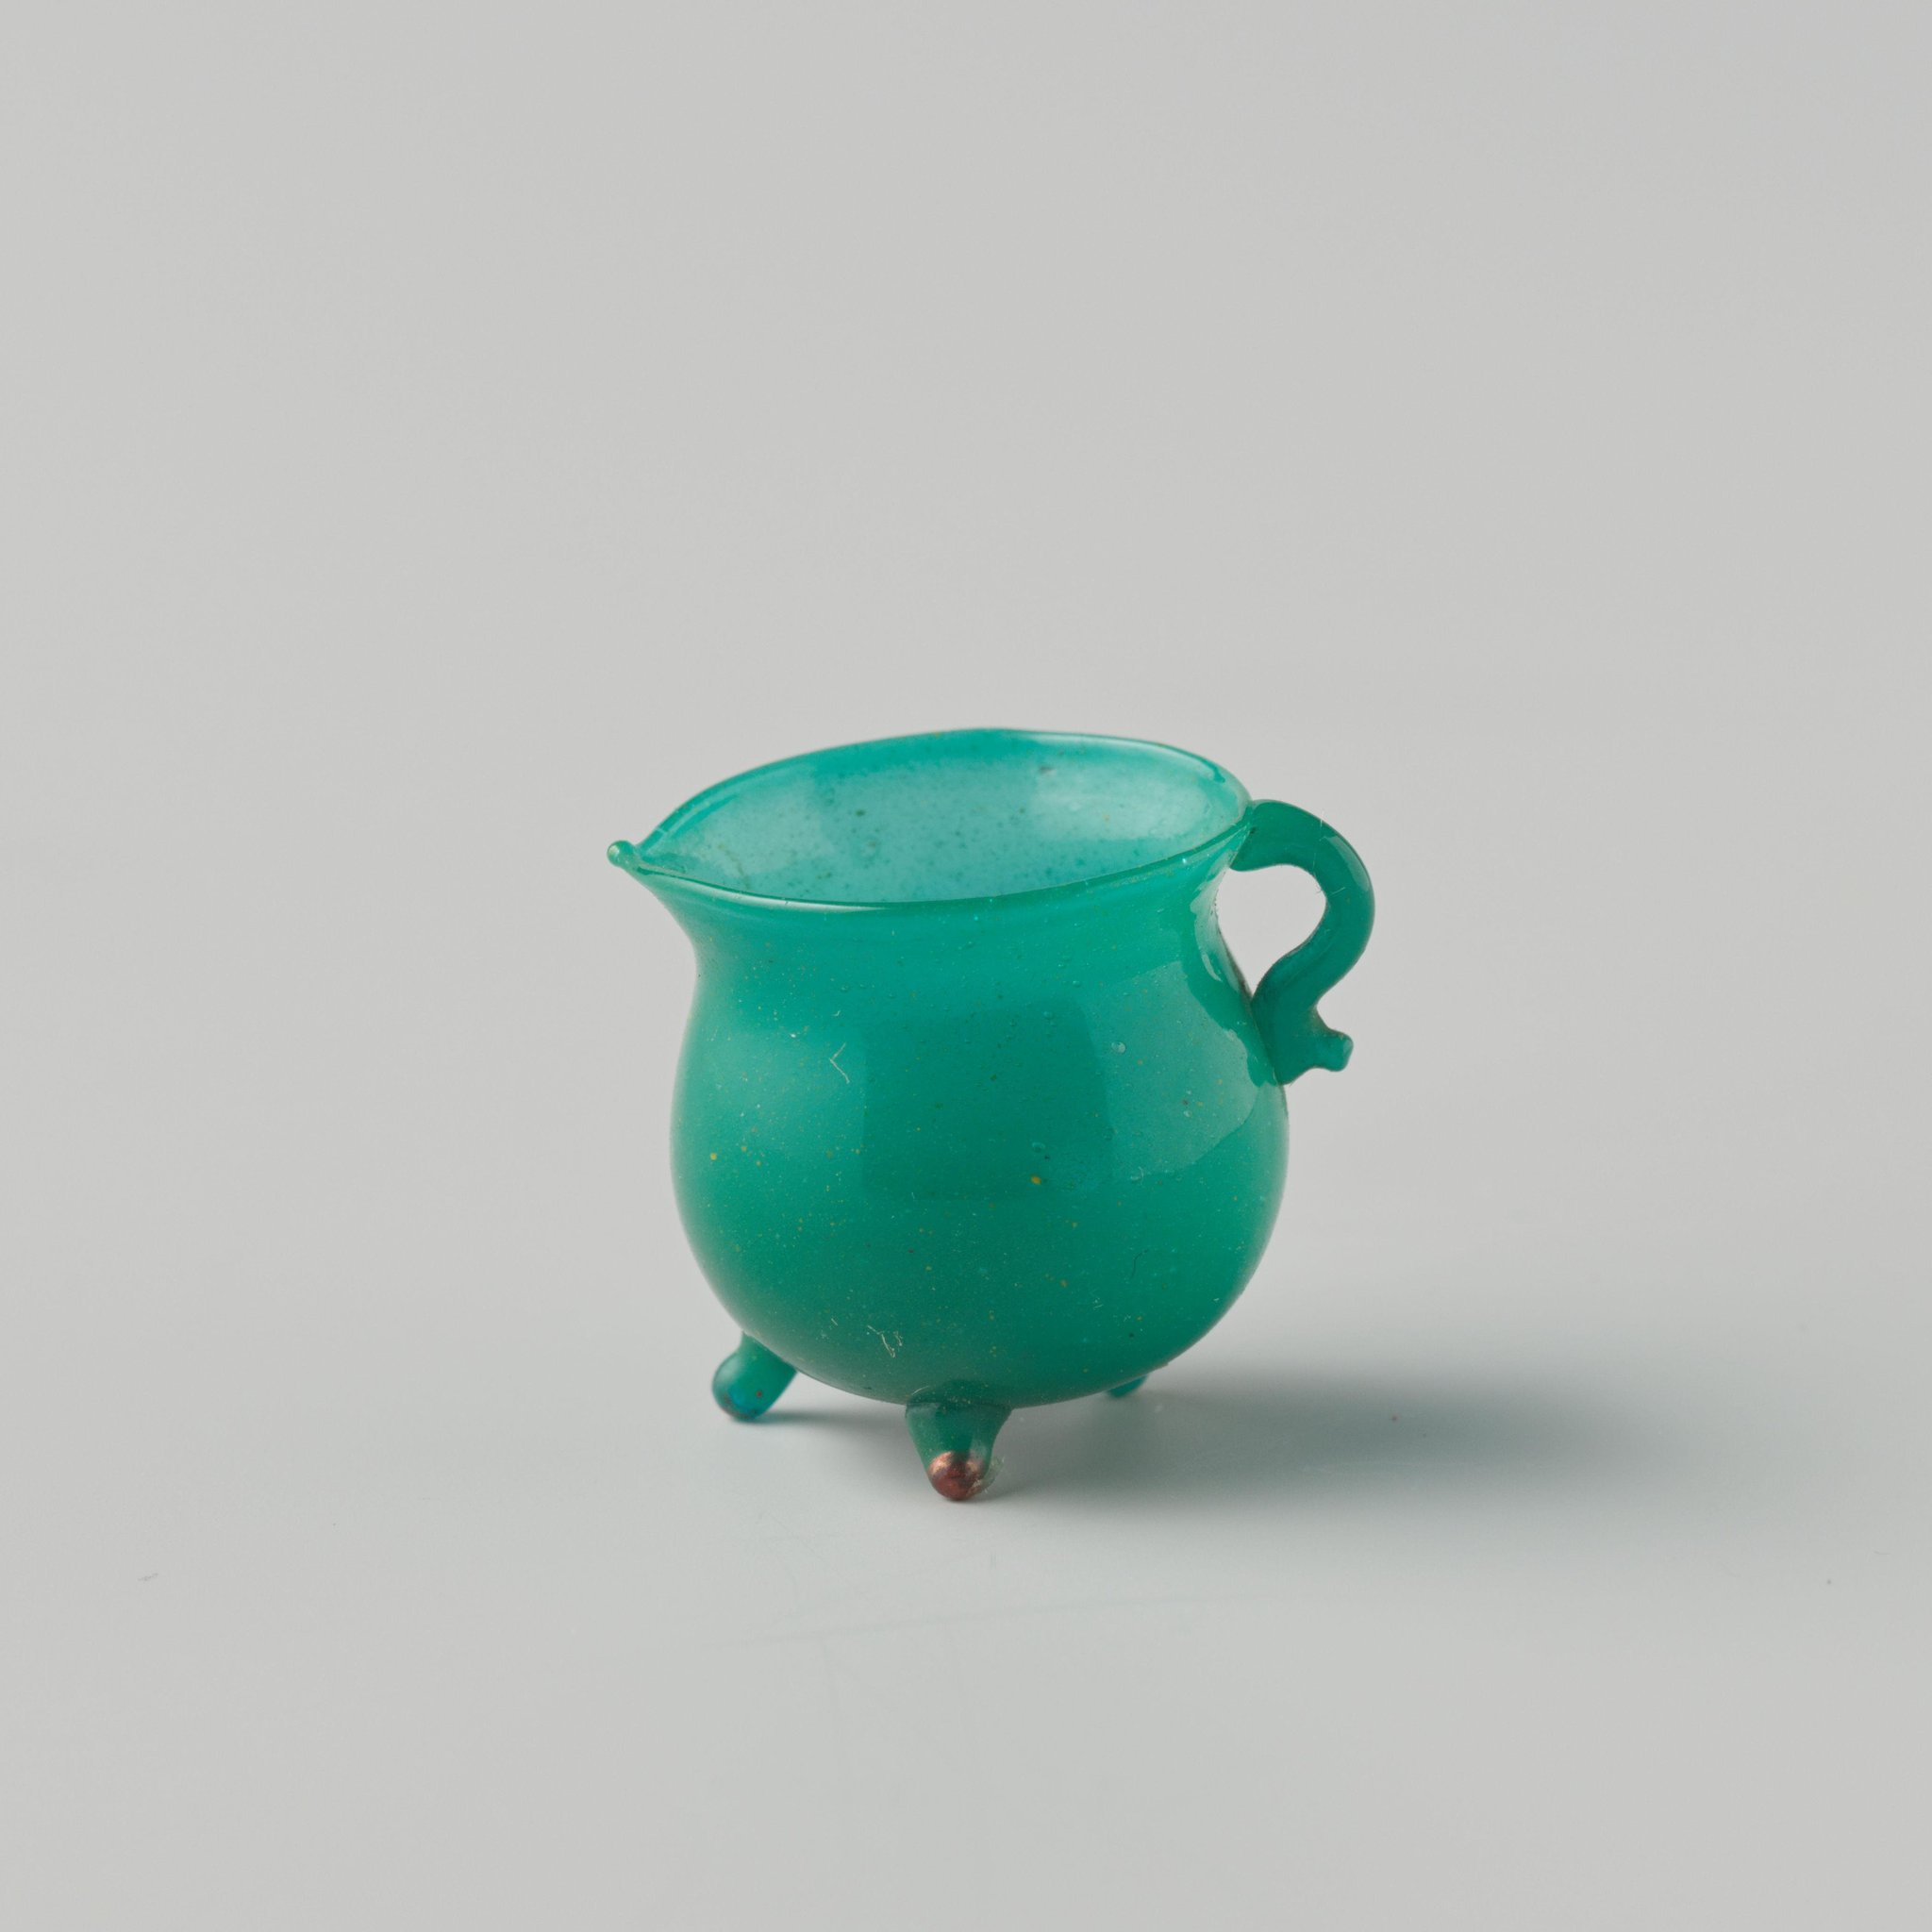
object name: ewer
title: Kookkan van opaak groen glas (waarschijnlijk imitatie groen aardewerk); op drie pootjes, met schenklip en oor.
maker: Anonymous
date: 1675-1710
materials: glass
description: Kookkan van opaak groen glas, waarschijnlijk imitatie groen aardewerk; op drie pootjes, met schenklip en oor.